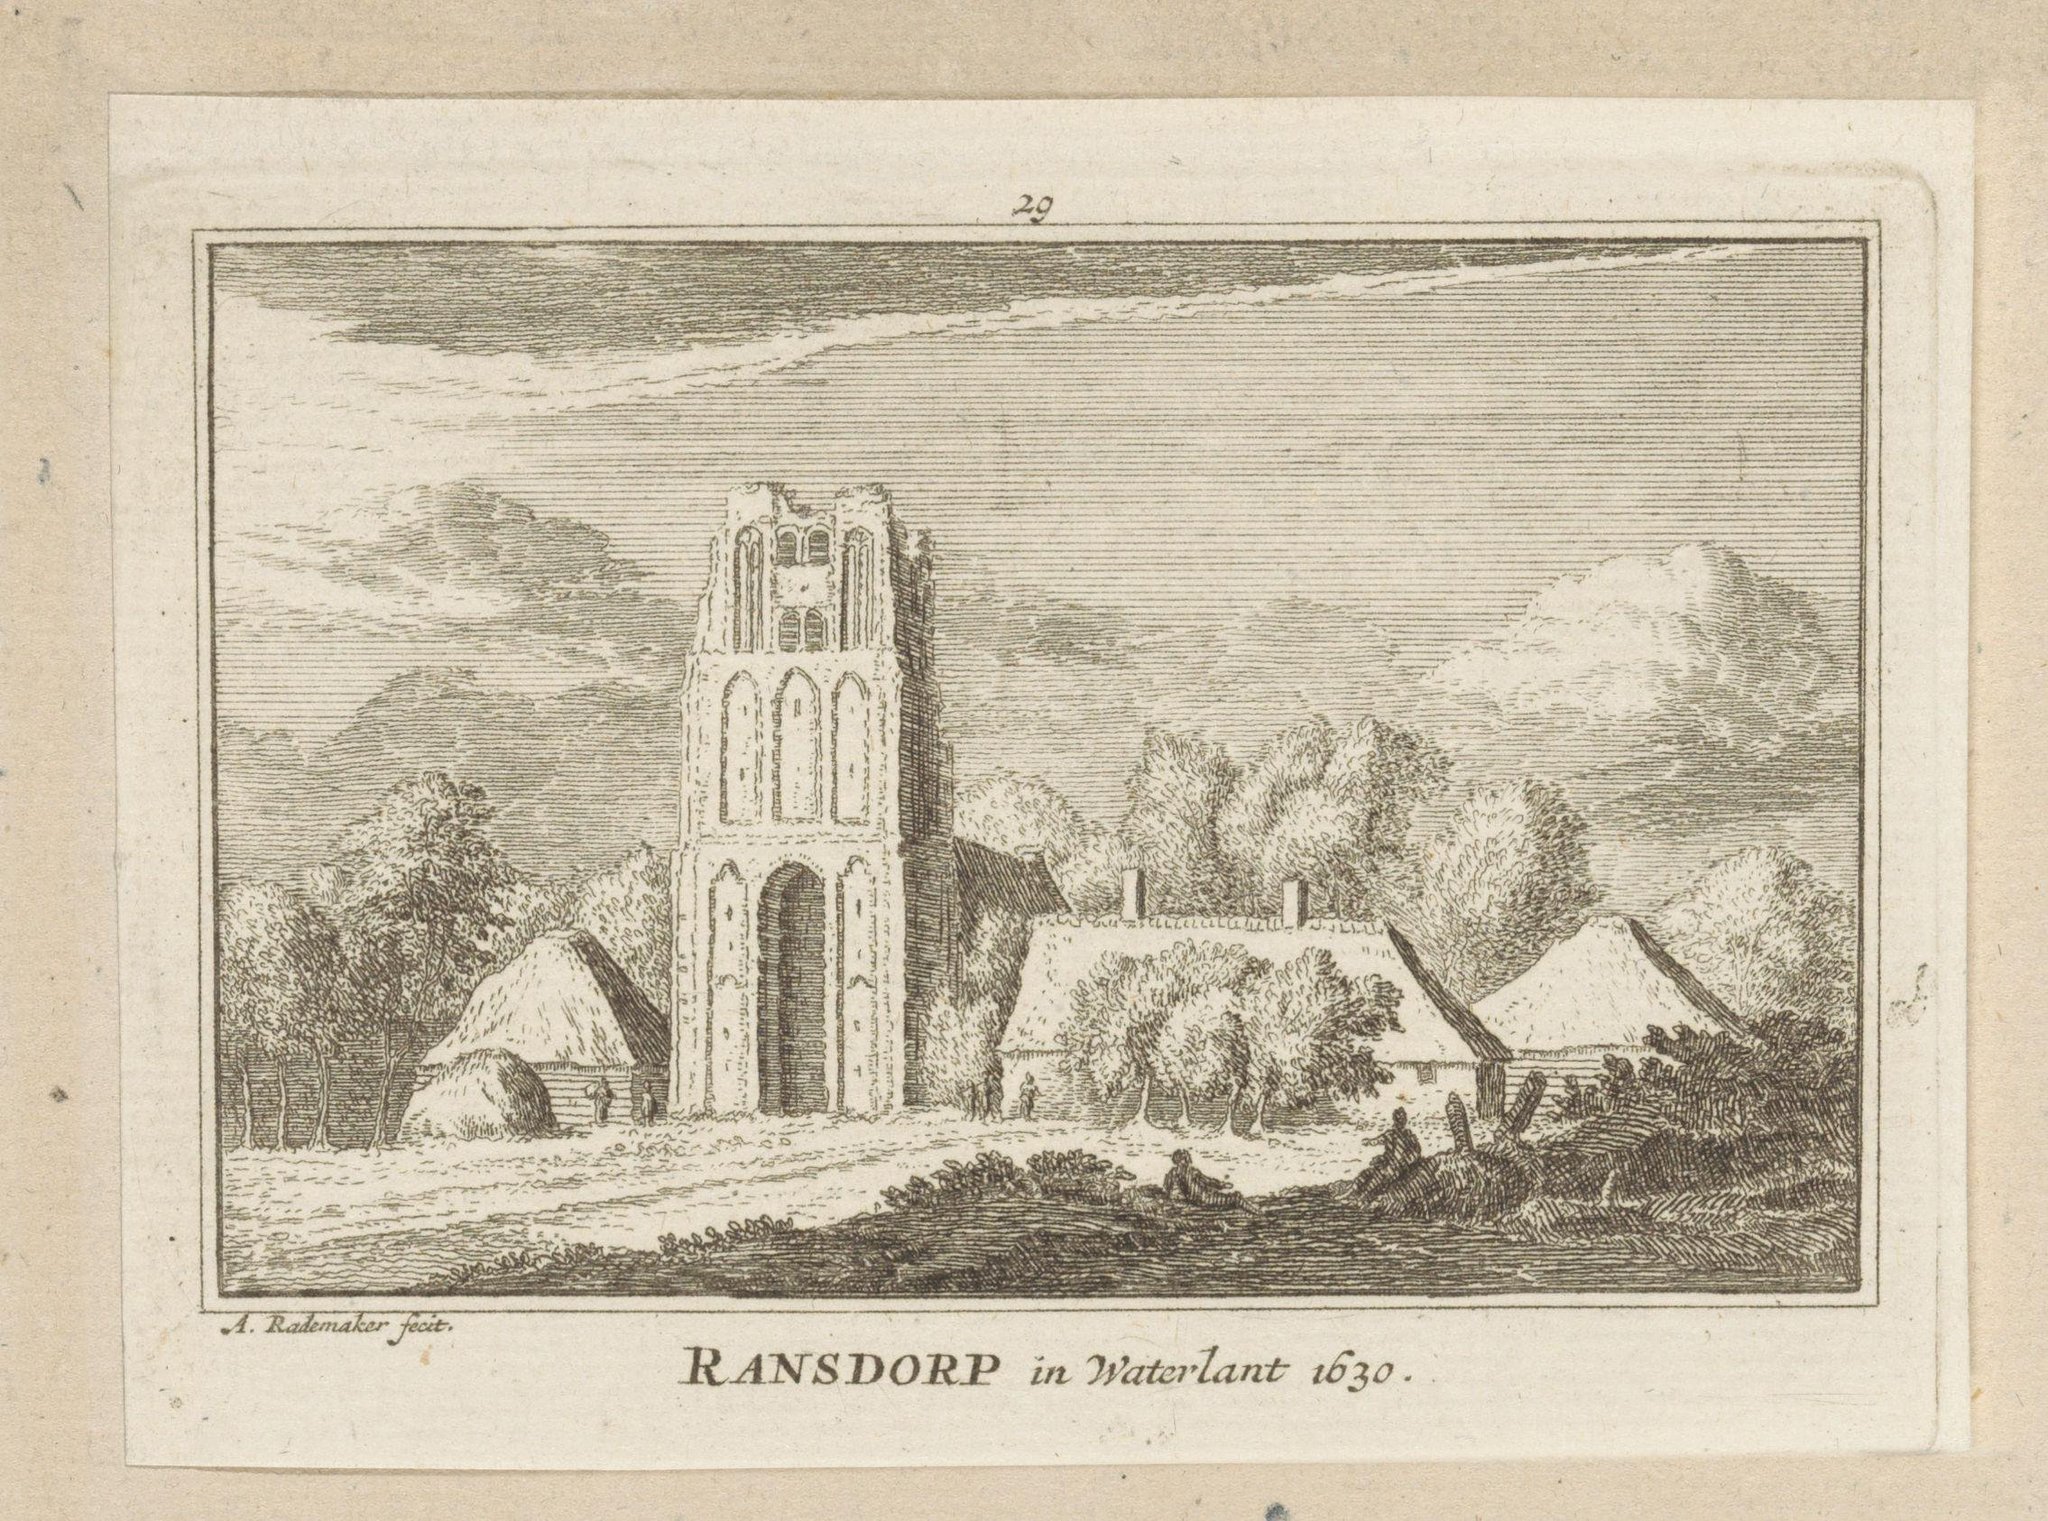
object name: print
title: Gezicht op Ransdorp, 1630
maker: abraham rademaker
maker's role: draughtsman, print maker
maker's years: 1676-1735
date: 1725-1803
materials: paper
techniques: engraving, etching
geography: amsterdam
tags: ruin of church, monastery, etc.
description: Prent ook gebruikt in: Rademaker, Abraham. Kabinet van Nederlandsche outheden en gezichten: vervat in 300 konstplaaten (…). 2 delen. Amsterdam: Willem Barents, 1725, dl. 1, ill. 29. Na 1725 is deze prent nog in verschillende heruitgaven verschenen, uitgegeven in 1727-1733, 1770-1771 en 1792-1803. Uit welke uitgave het huidige exemplaar precies komt is niet na te gaan.